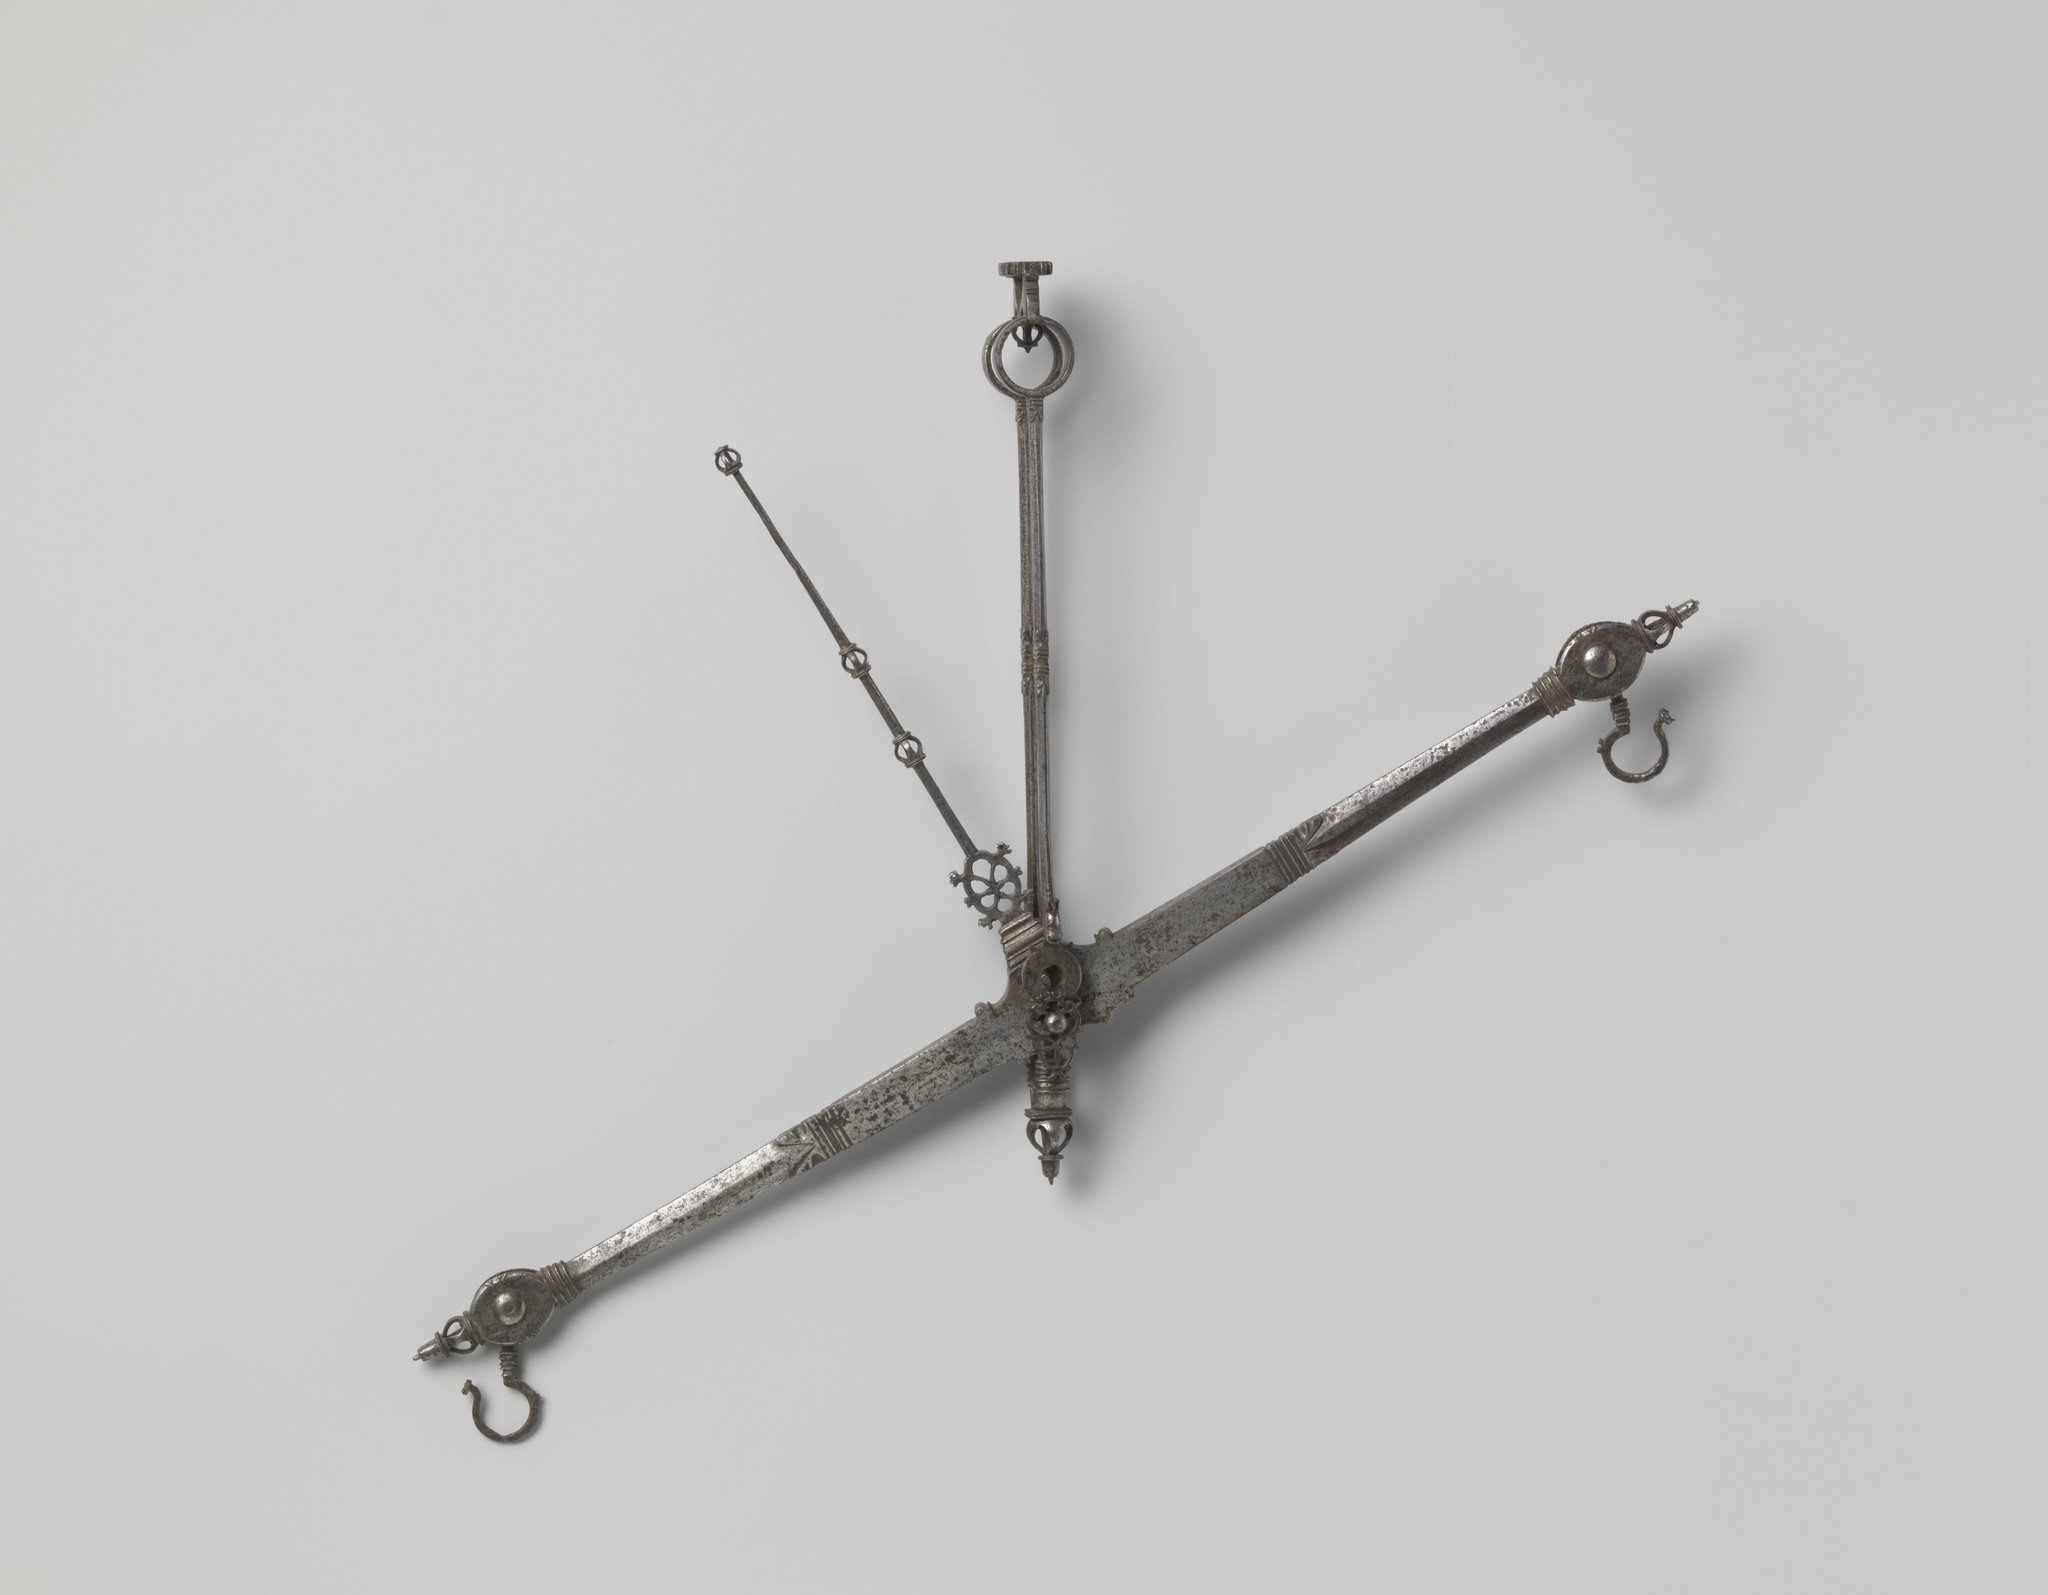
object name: balance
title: Balans van ijzer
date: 1500-1600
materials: iron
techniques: forging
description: Een gesmeed ijzeren balans. De armen van de balans verkleinen zich naar de uiteinden van rechthoekige tot achtkante doorsnede en eindigen in een ajour gewerkte knop, de evenaar is bij het begin roosvormig opengewerkt en heeft drie ajour gewerkte knoppen. Het huis, met twee ogen om het mes verbonden, bestaat uit twee achtkante spijlen, die overgaan in ringen, waarop een ovaal tafel rust met opening voor de haak. Een sierlijk gesmede hanger, aan het huis bevestigd, accentueert het midden van de balans.